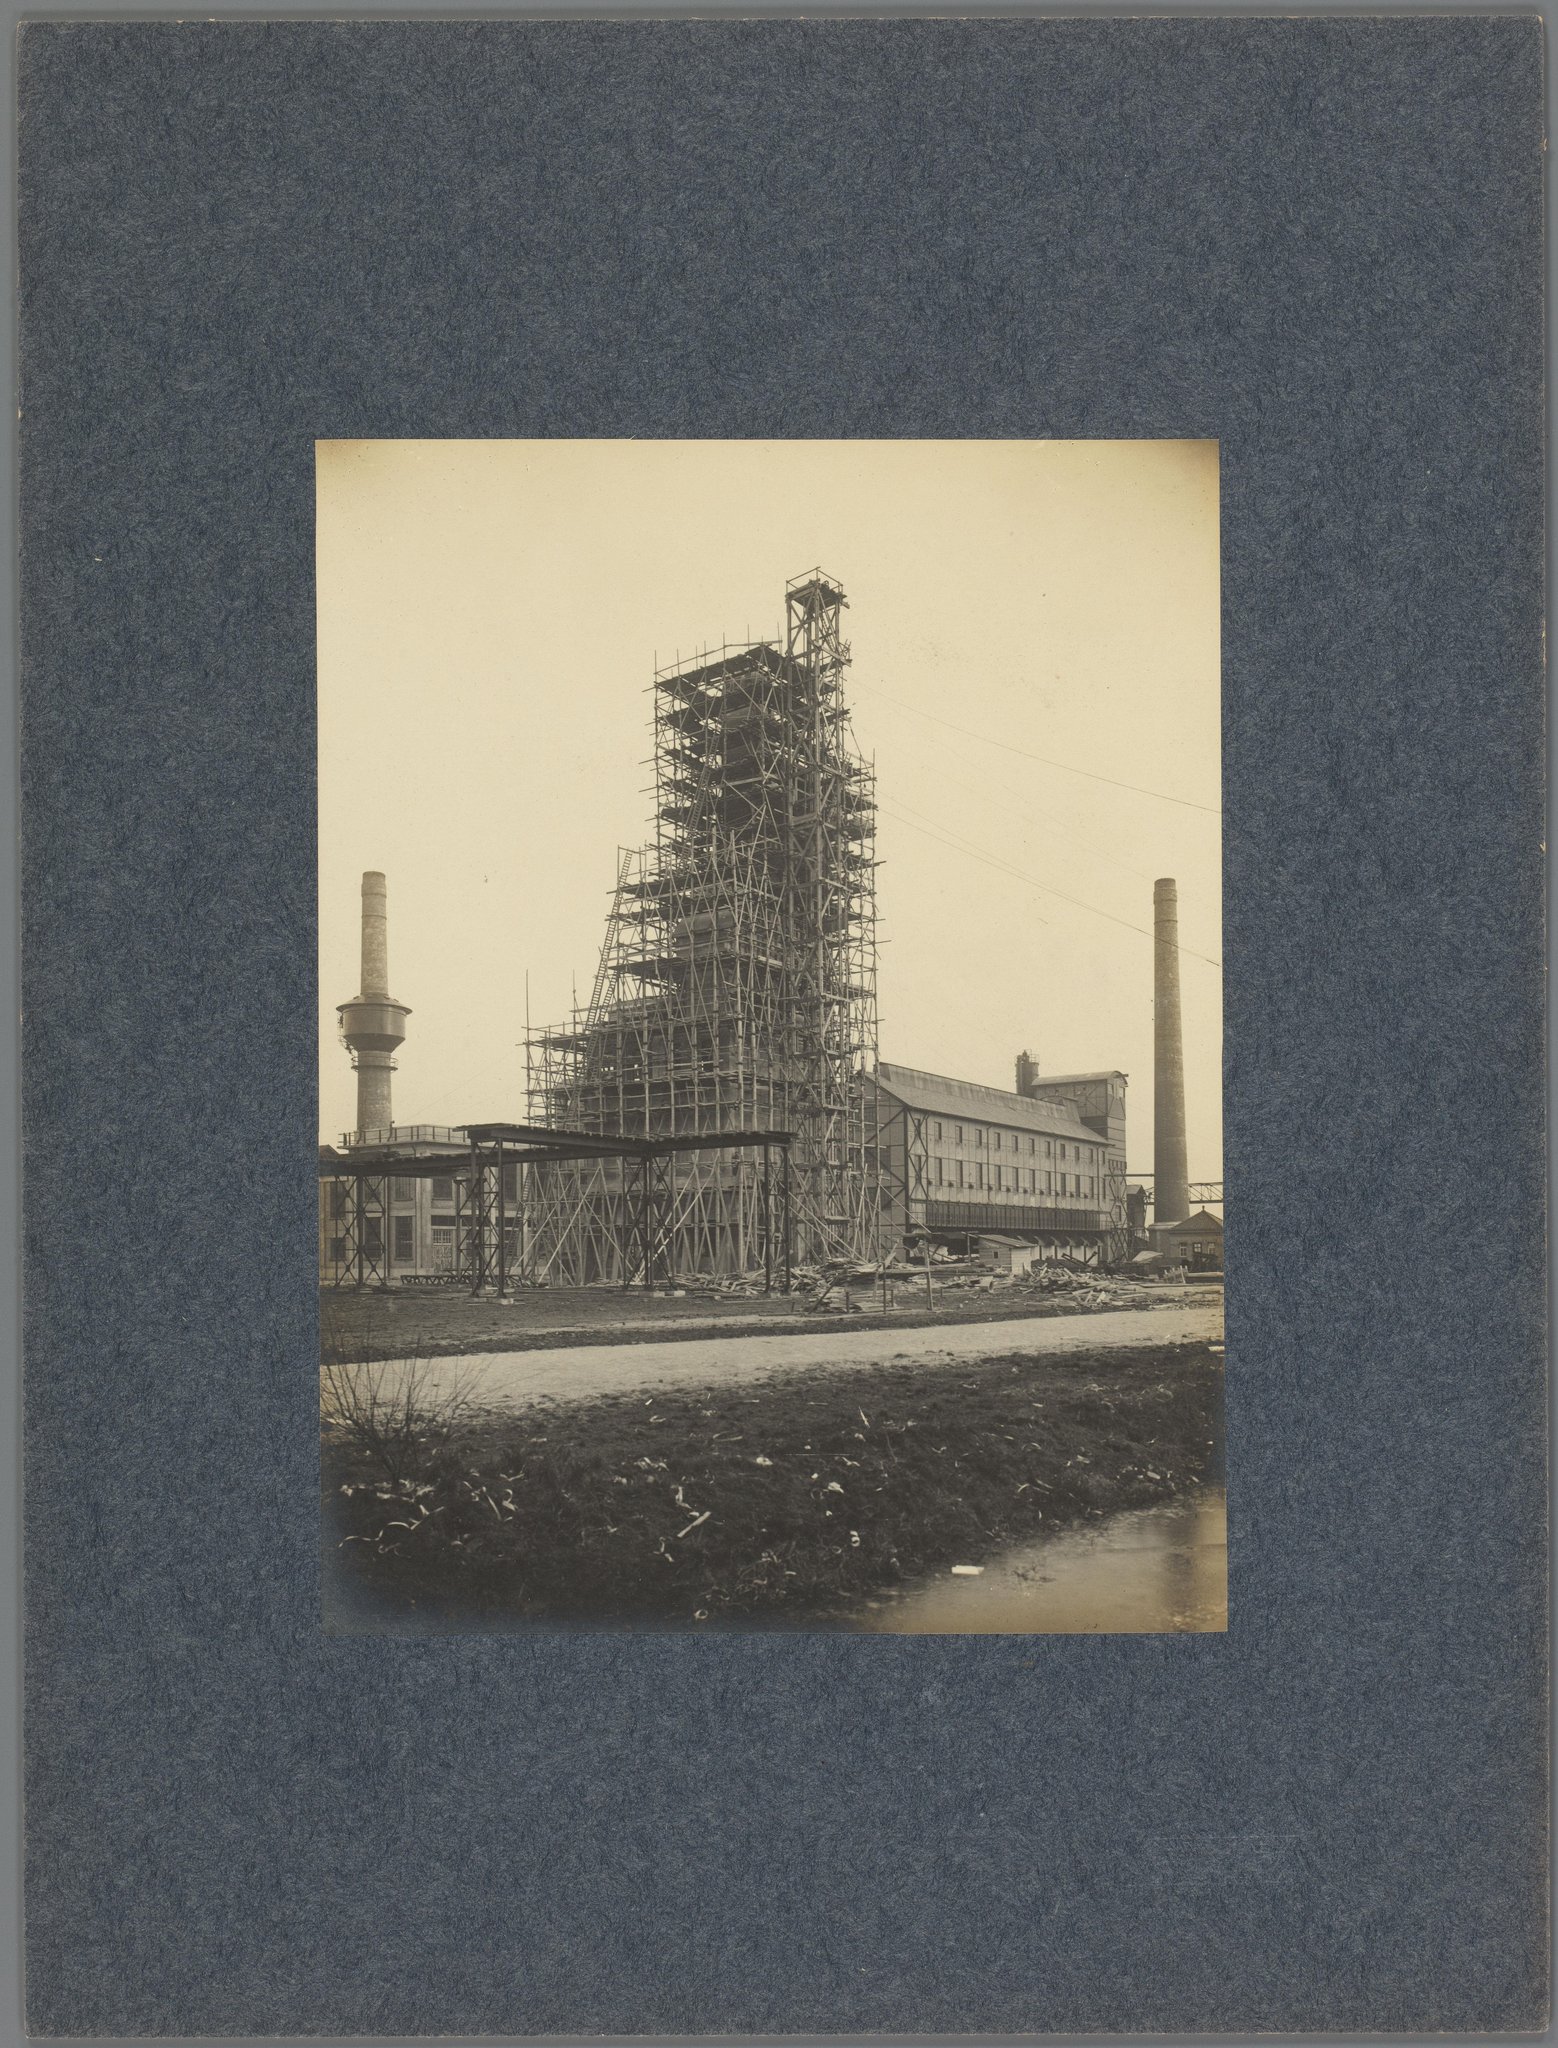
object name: photograph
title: Bouw van een fabriek, Rotterdam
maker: willem sr. bleuzé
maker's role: fotograaf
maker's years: 1873-1948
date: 1909-1919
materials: paper, cardboard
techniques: gelatin silver print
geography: rotterdam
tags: warehouse (~ harbour), factory-building, building-site, rotterdam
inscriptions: address: ‘W. BLEUZÉ/ ROTTERDAM/ JONKER FRANSSTRAAT 66’